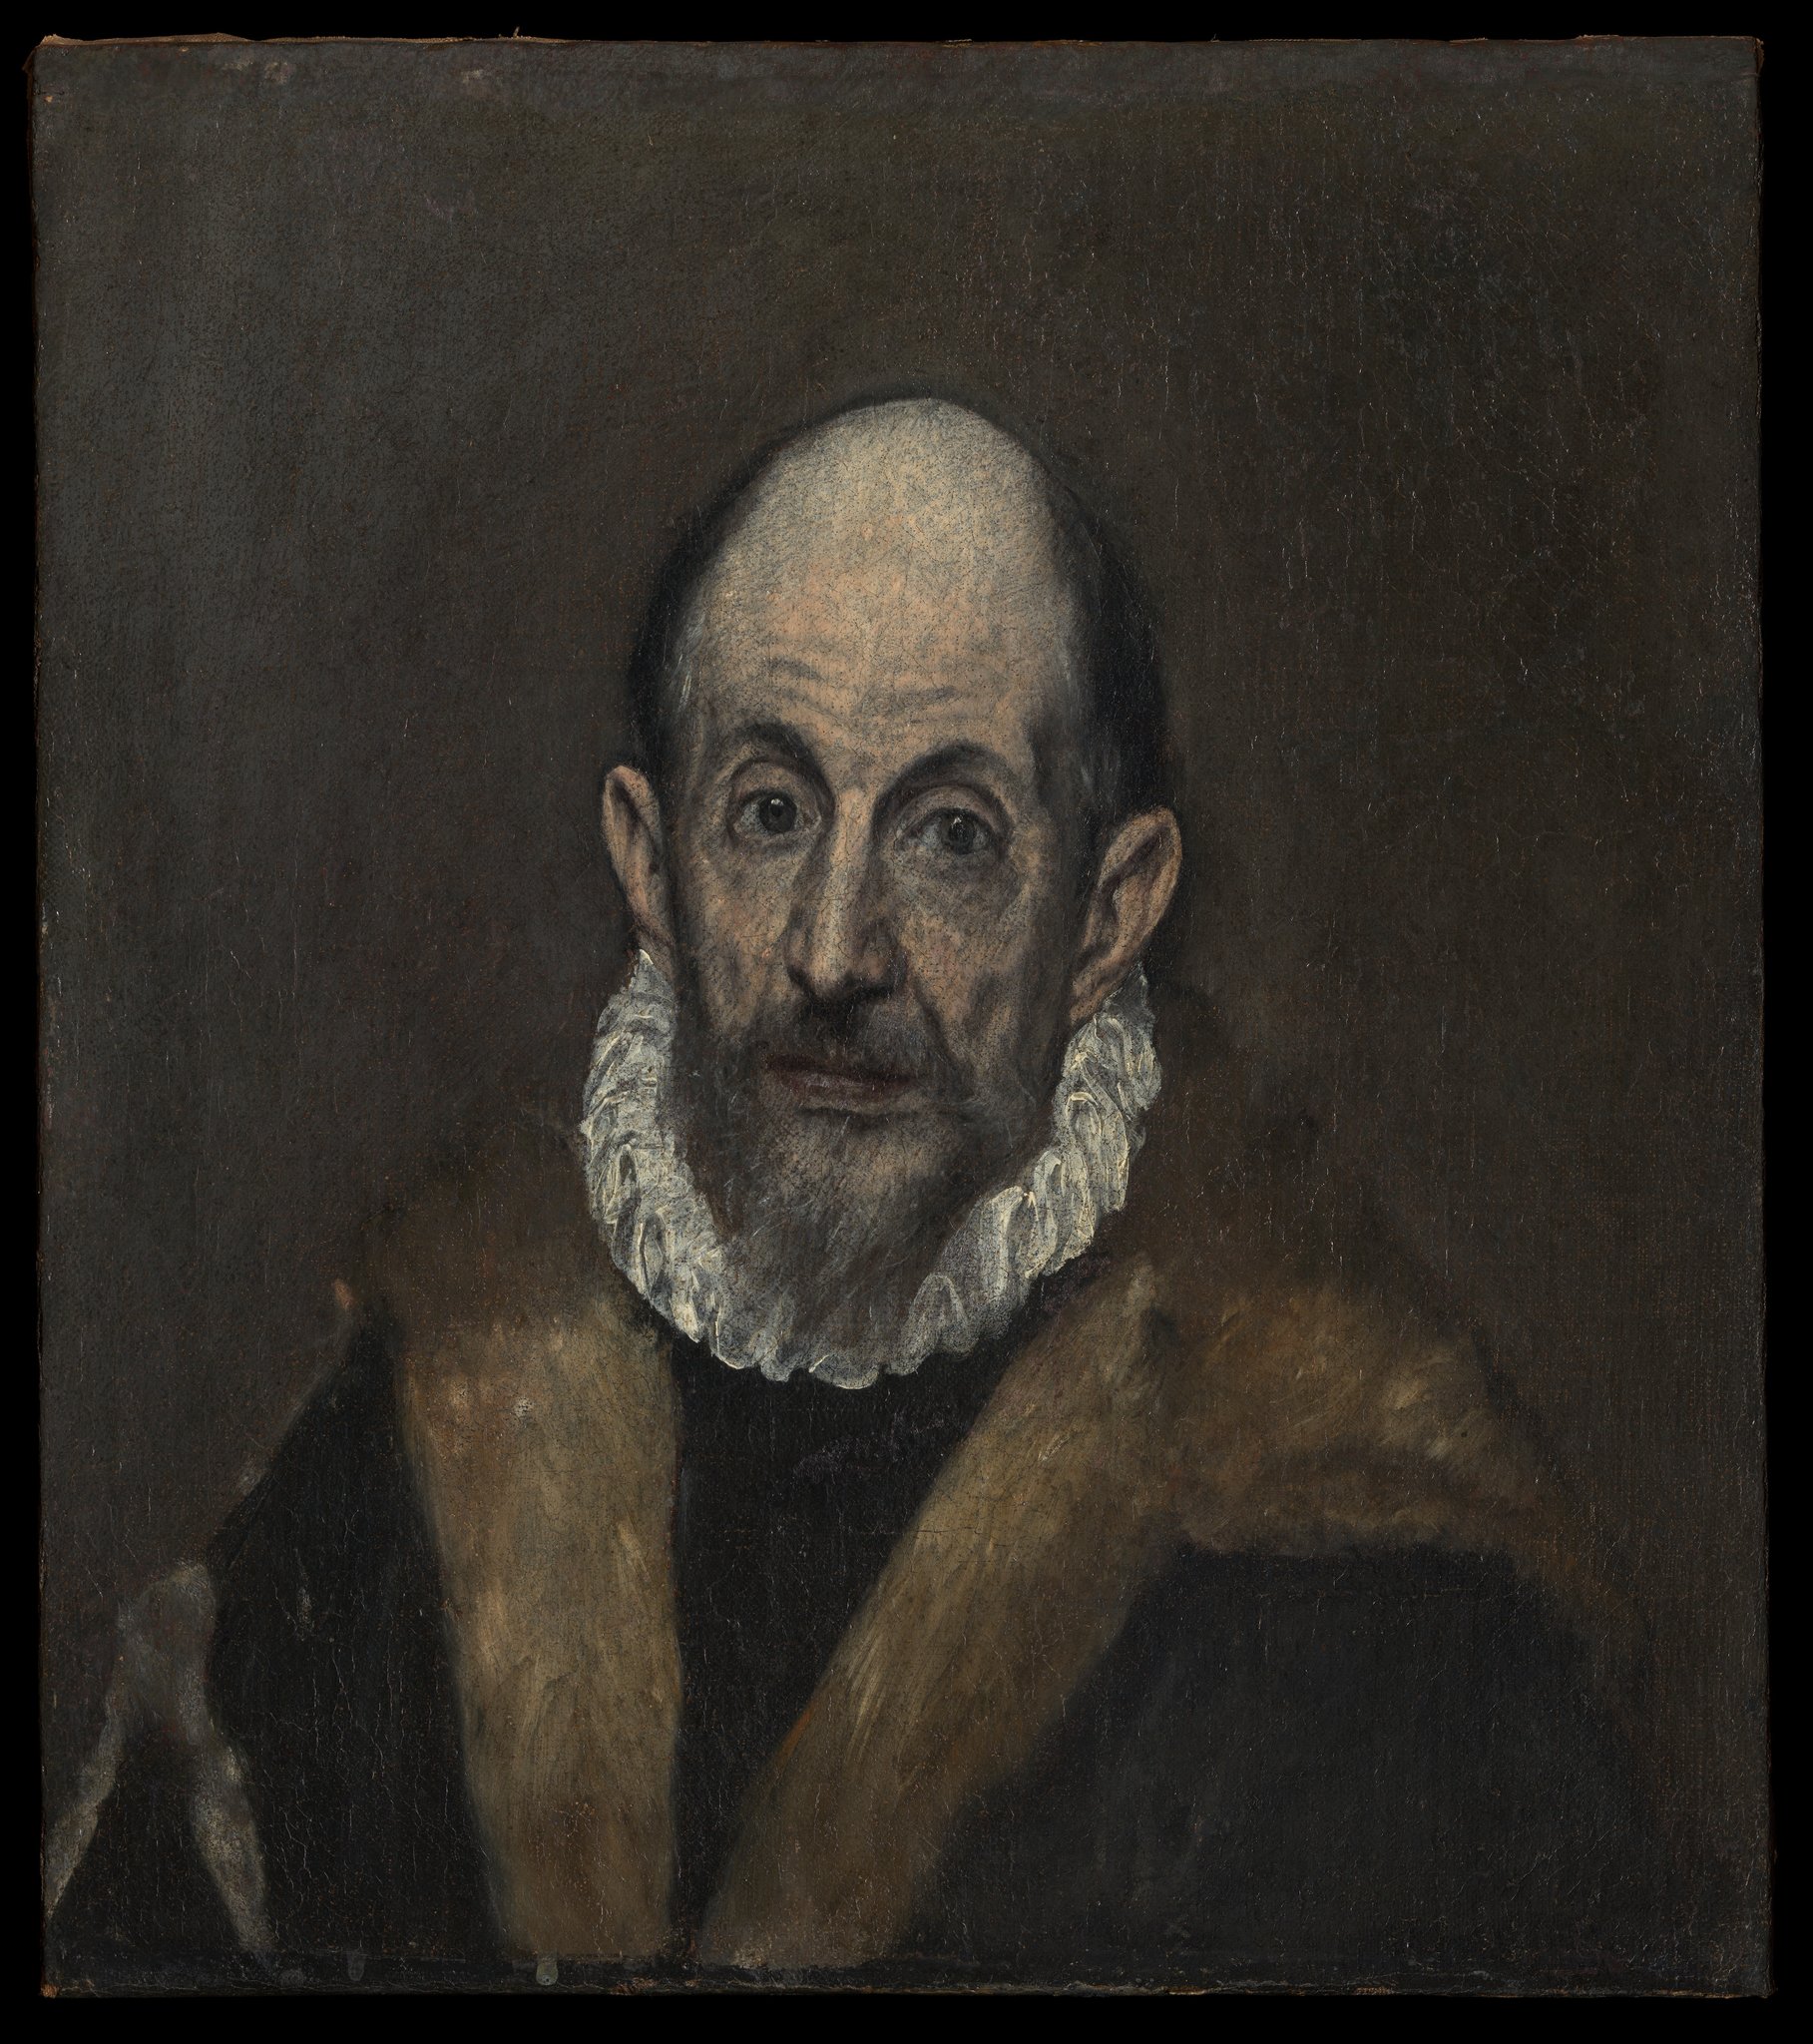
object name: painting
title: Portrait of an Old Man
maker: el greco (domenikos theotokopoulos)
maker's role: artist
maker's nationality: greek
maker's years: 1540-1614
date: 1595-1600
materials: canvas, oil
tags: men,portraits